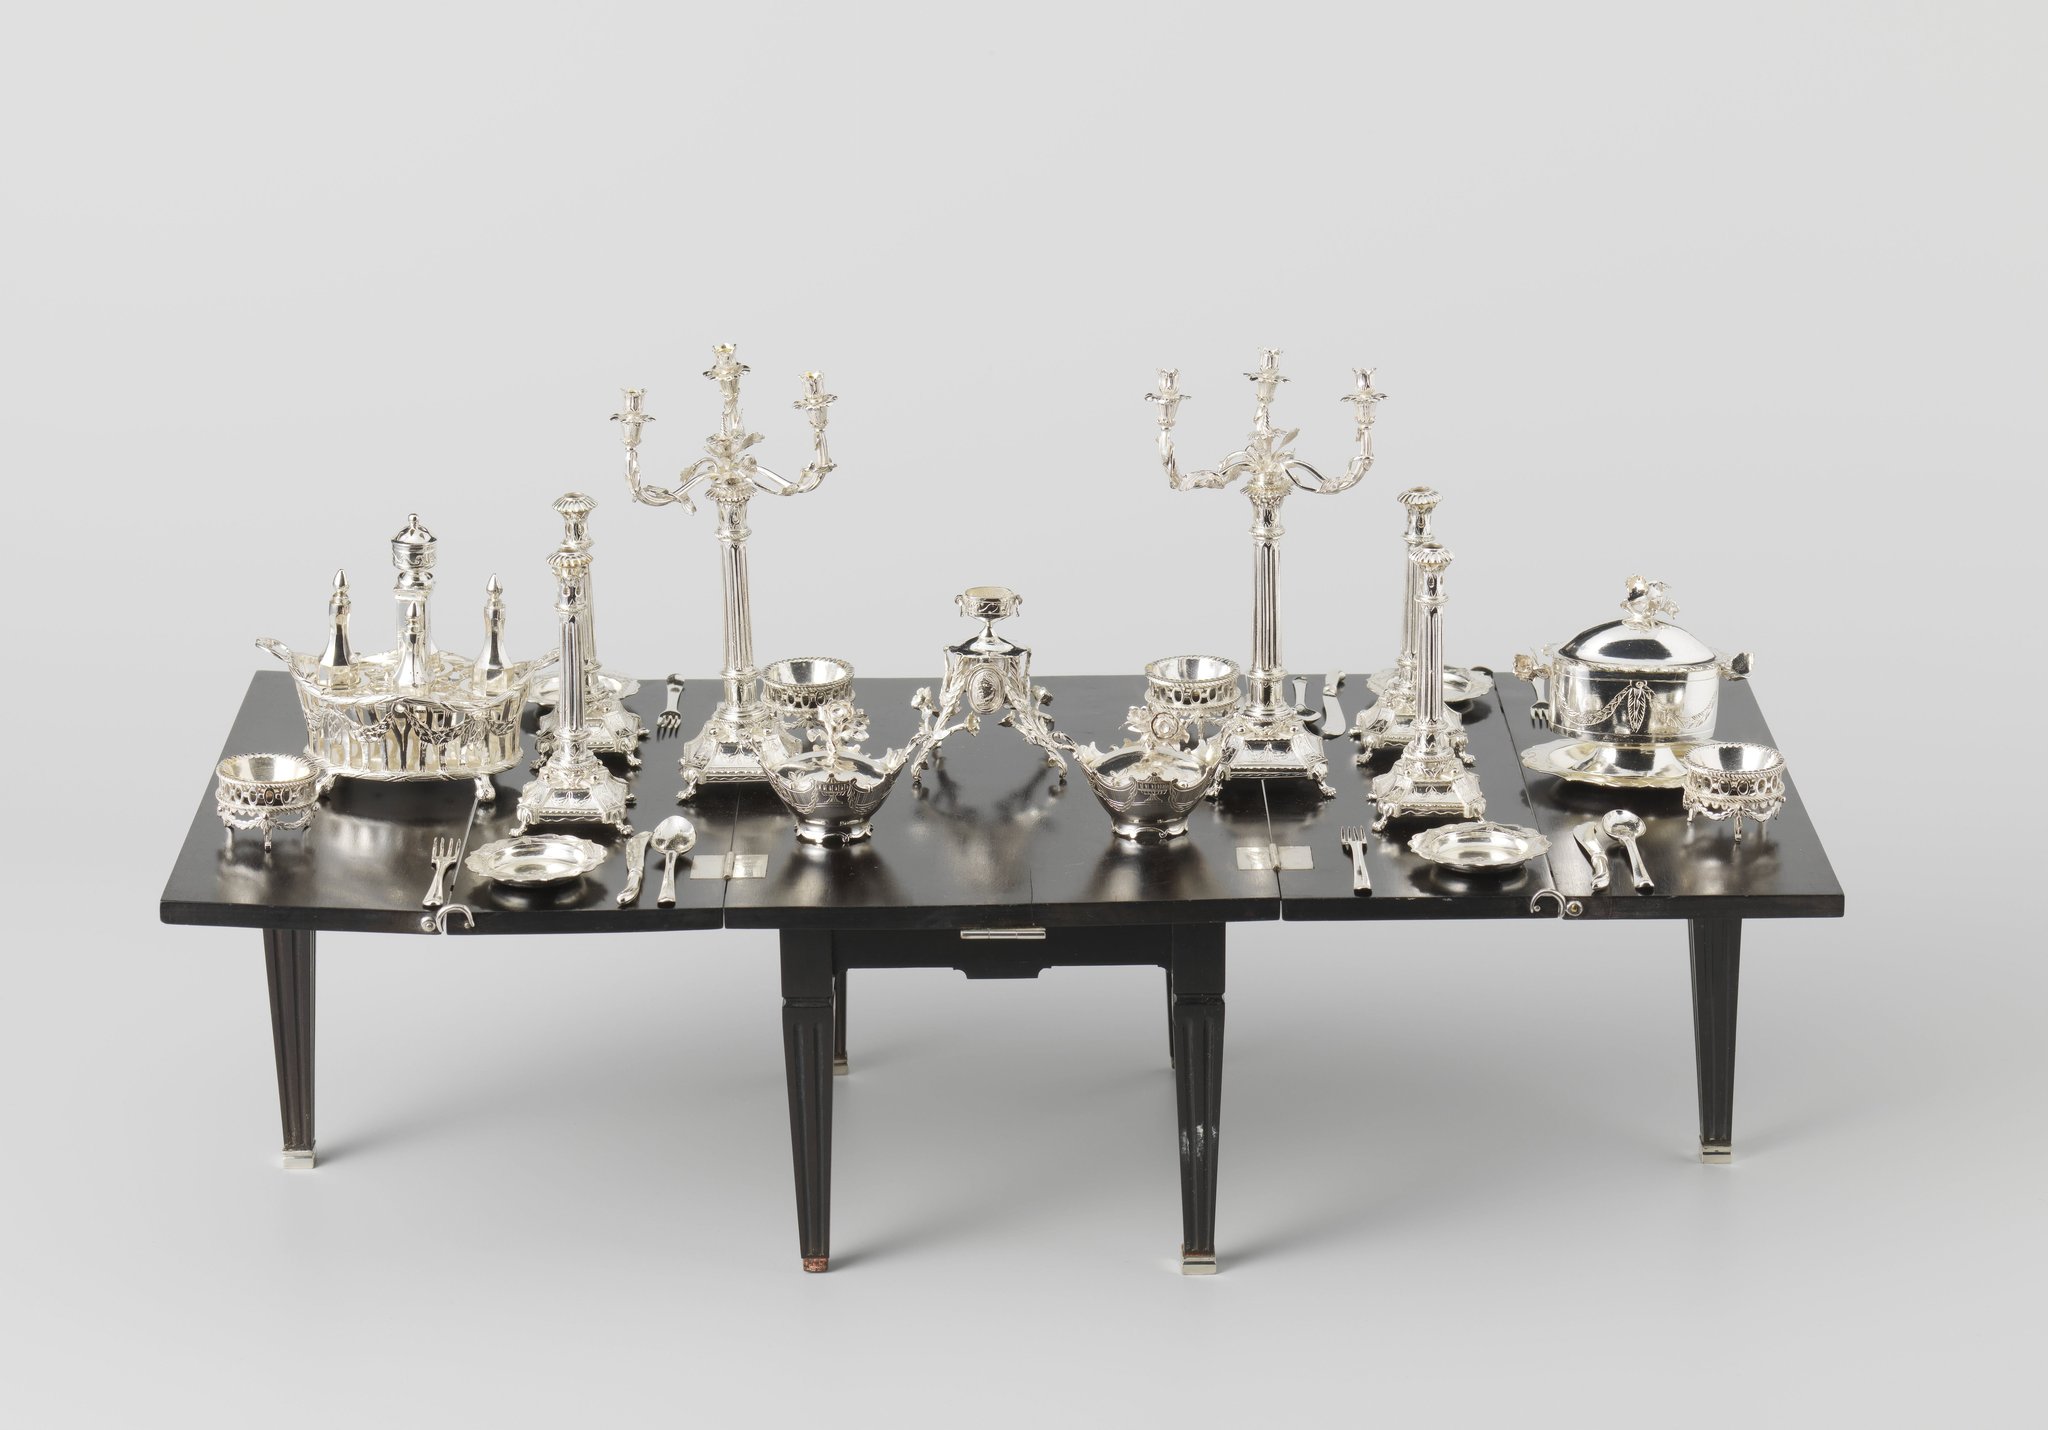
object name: miniature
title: Bord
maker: Anonymous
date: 1782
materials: silver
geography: amsterdam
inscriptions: maker's mark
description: Rond eetbord met geschulpte rand. Op de rand zijn guirlandes gegraveerd.In het midden van het bord is een bloem gegraveerd. Het bord is gemerkt: stk.= Amsterdam, jrl.= X (1782) en mt.= Voet 430. Het bord is een exemplaar van een set bestaande uit 36 identieke borden (BK-NM-11177-189 t/m BK-NM-11177-224).